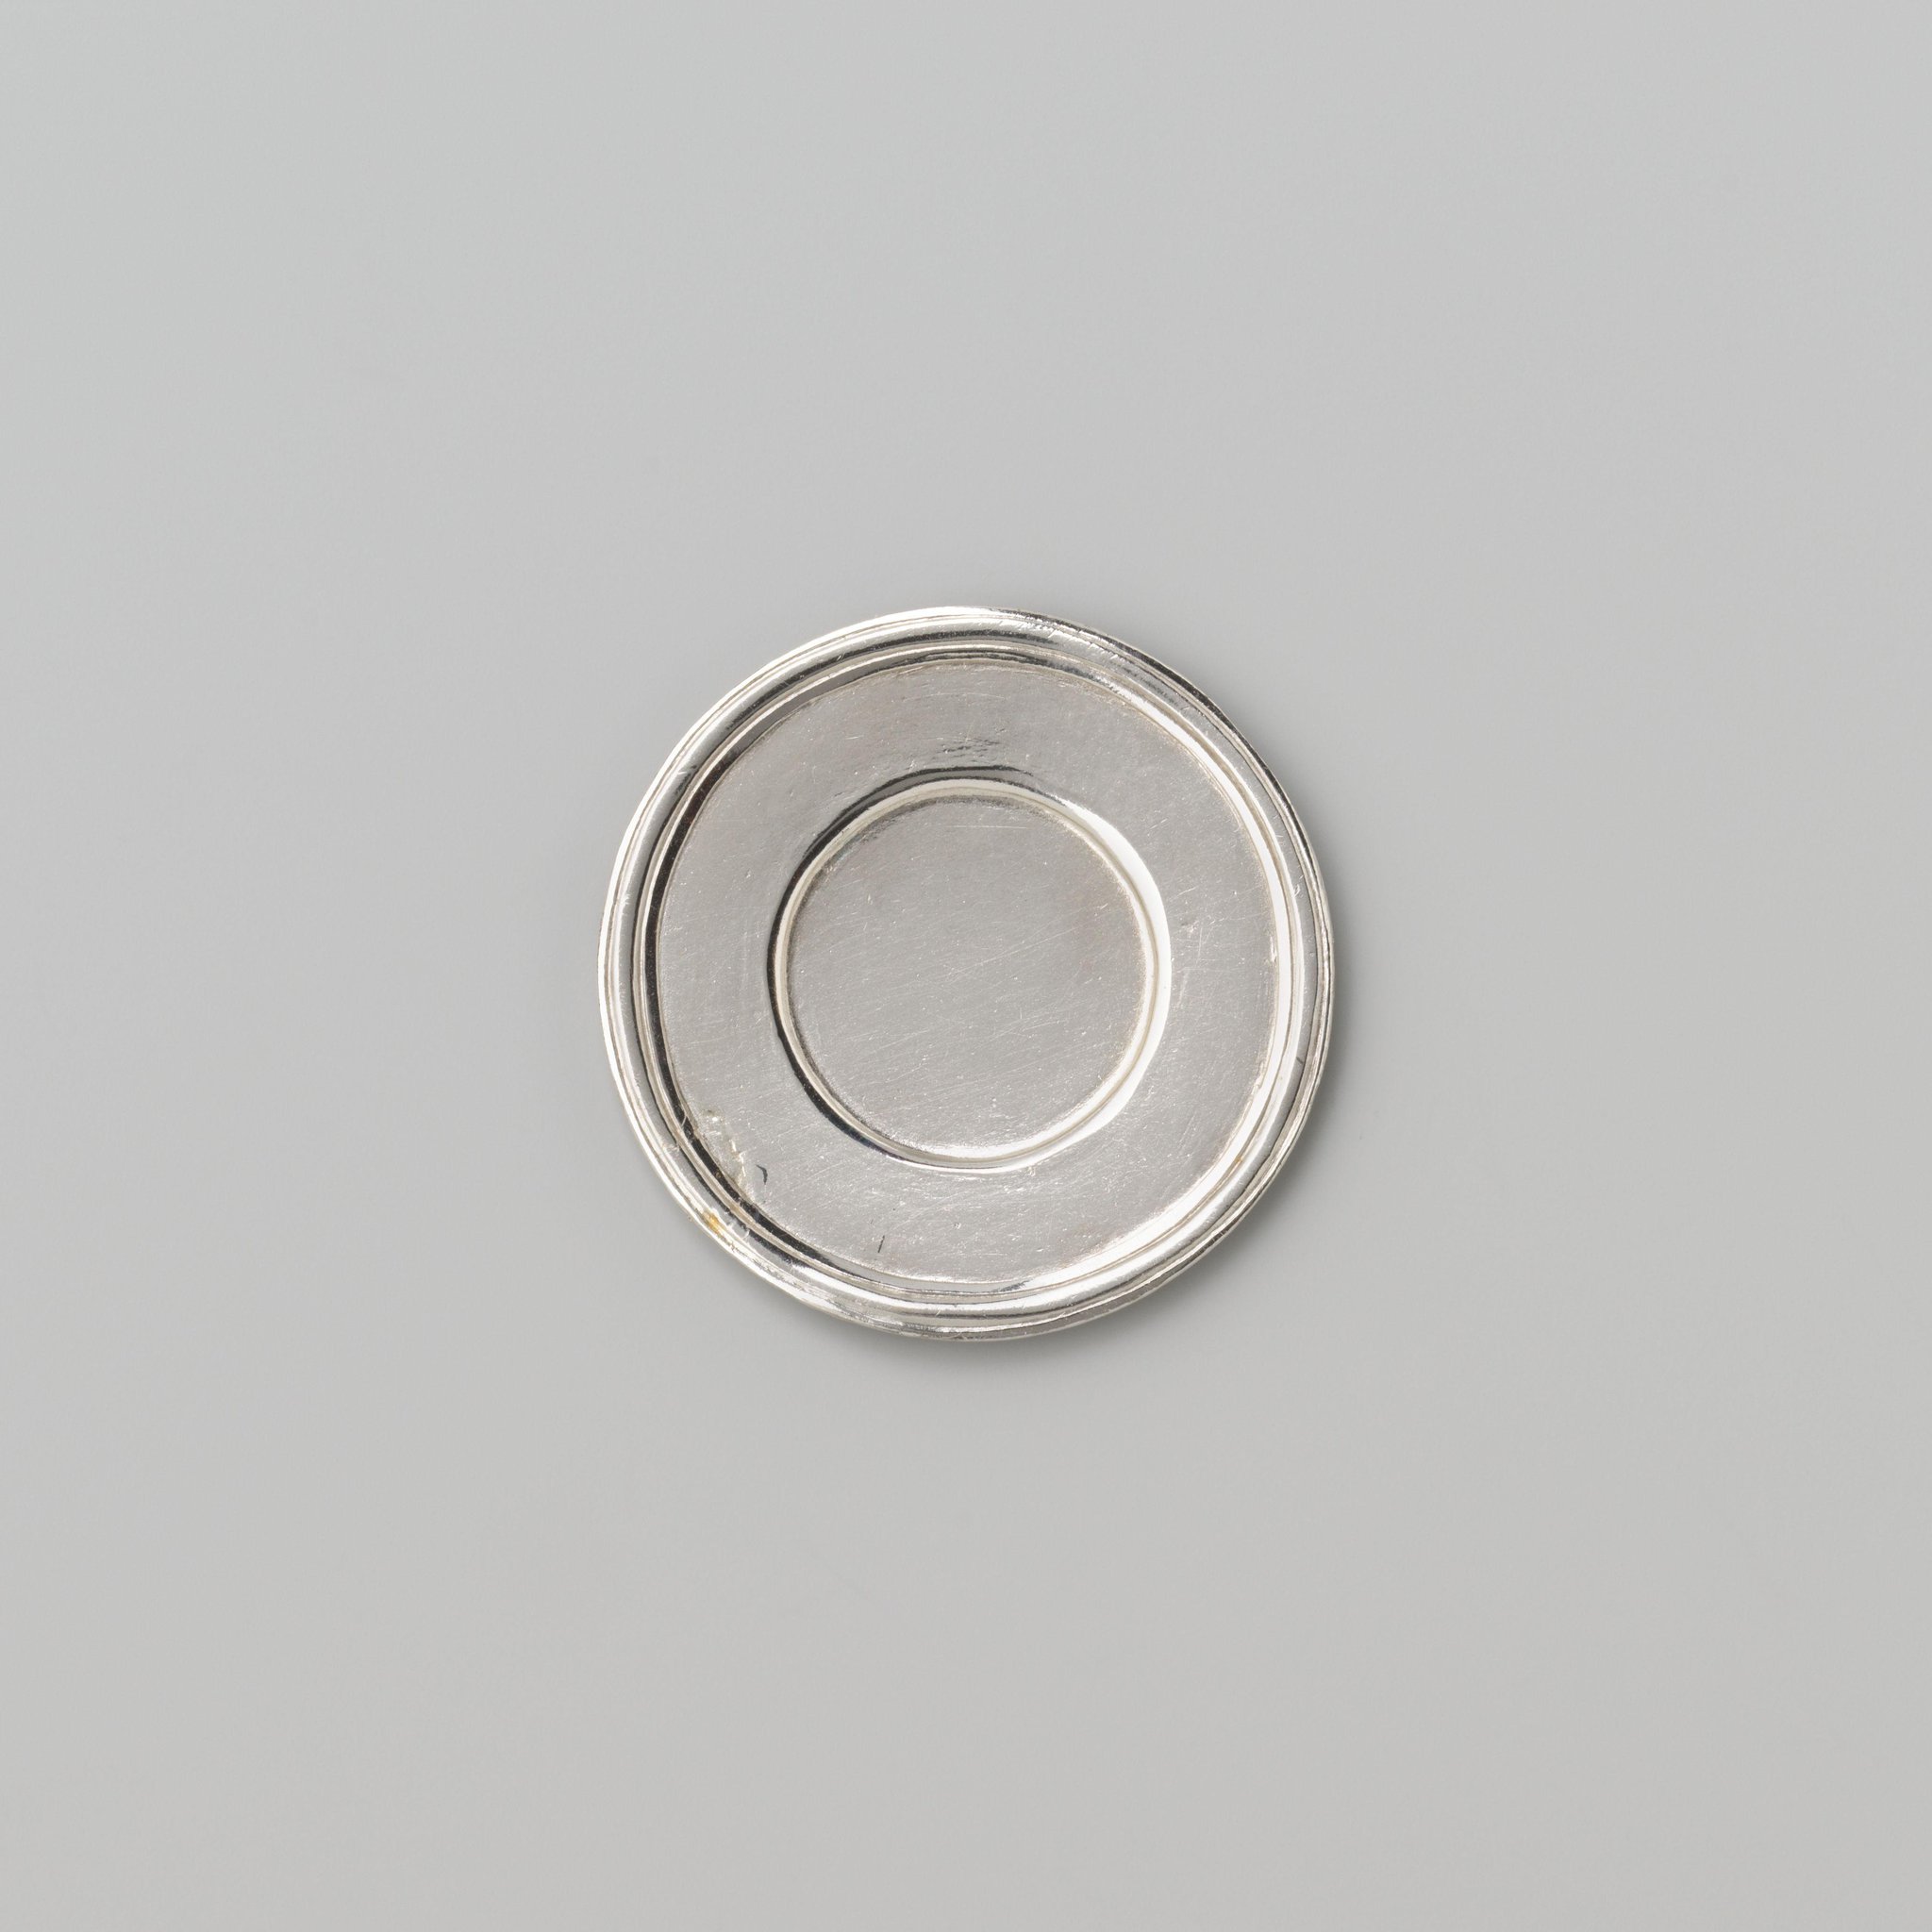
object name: plate dish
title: Zilverkleurige schoteltje met brede platte geprofileerde rand.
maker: Anonymous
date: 1700-1710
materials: copper alloy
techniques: silvering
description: Zilverkleurige schotel met brede, platte geprofileerde rand.